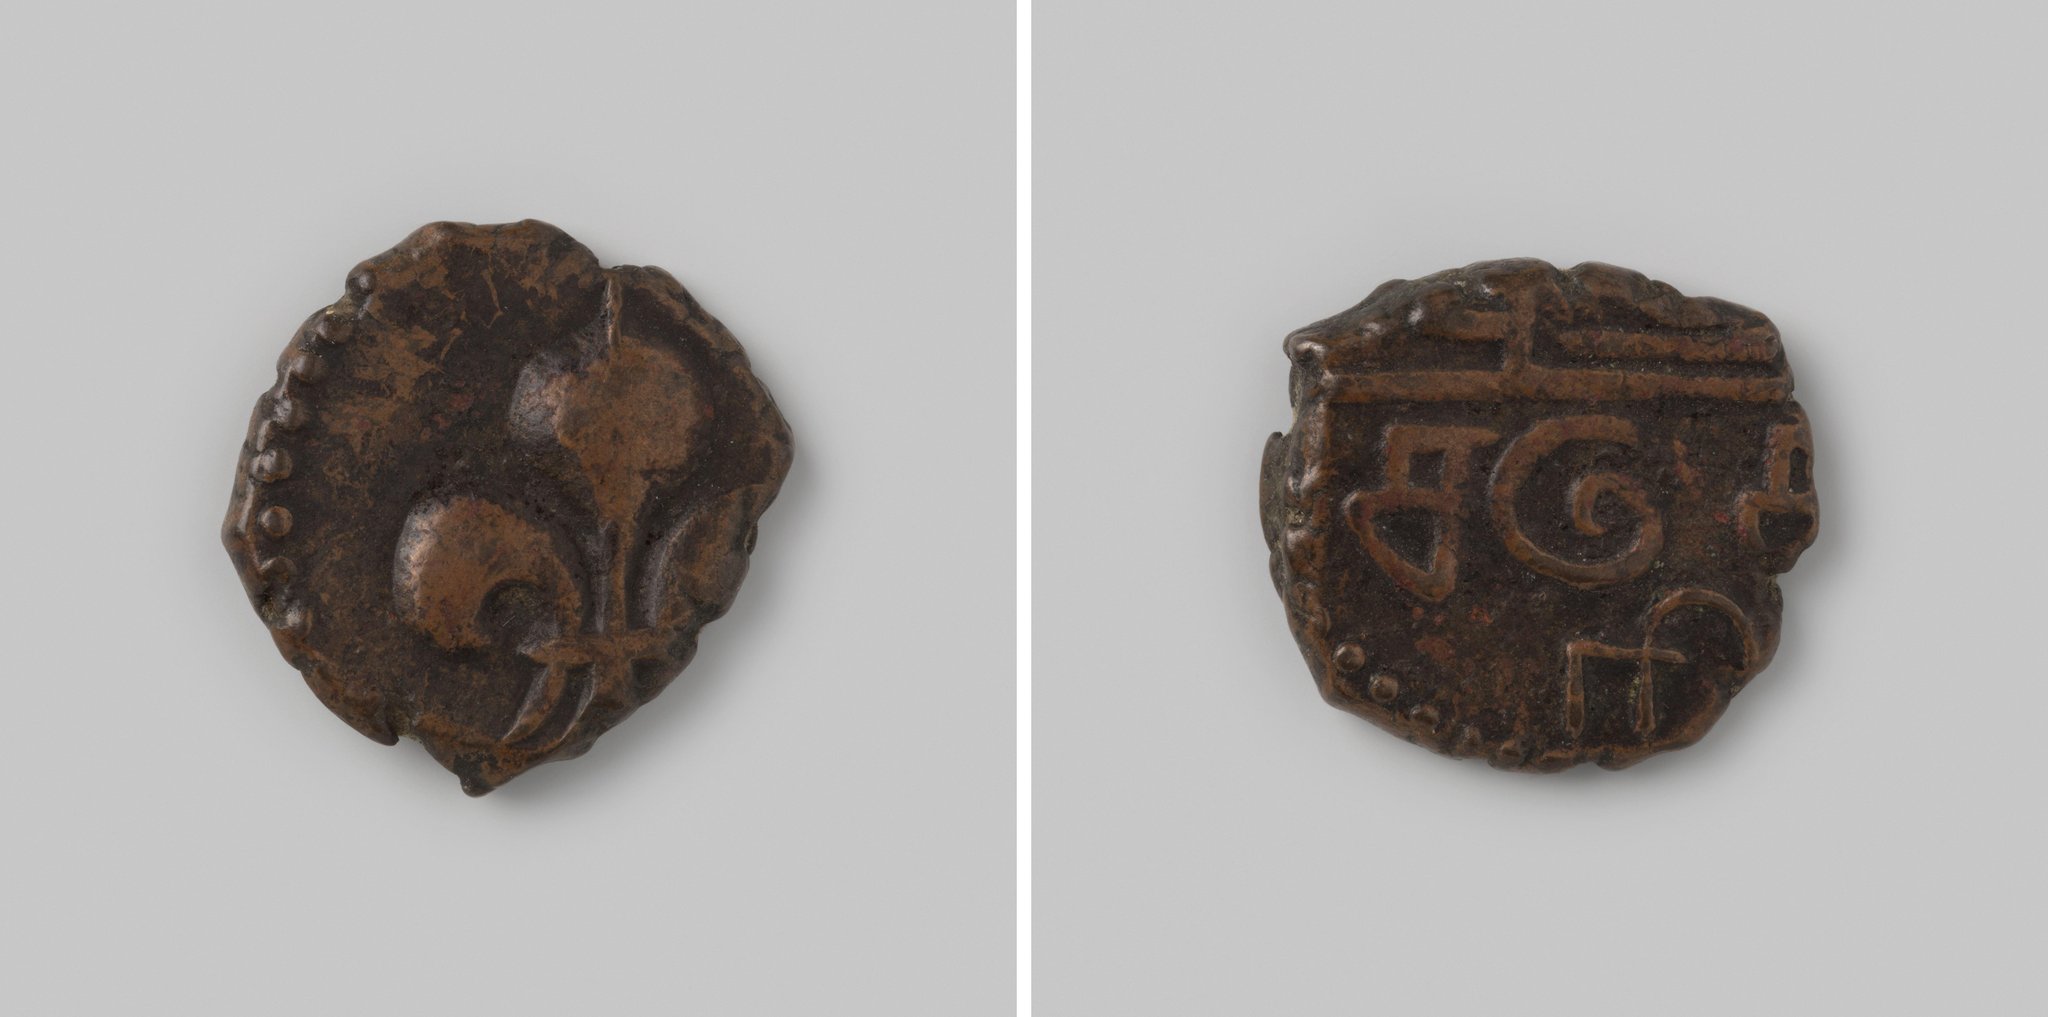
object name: coin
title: Doudou uit Pondicherry in India van de Franse Compagnie perpétuelle des Indes,1720-1837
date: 1720-1837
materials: copper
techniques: striking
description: Koperen munt. Voorzijde: lelie. Keerzijde: in Tamil-schrift in drie regels naam van de muntplaats: Pondicherry.